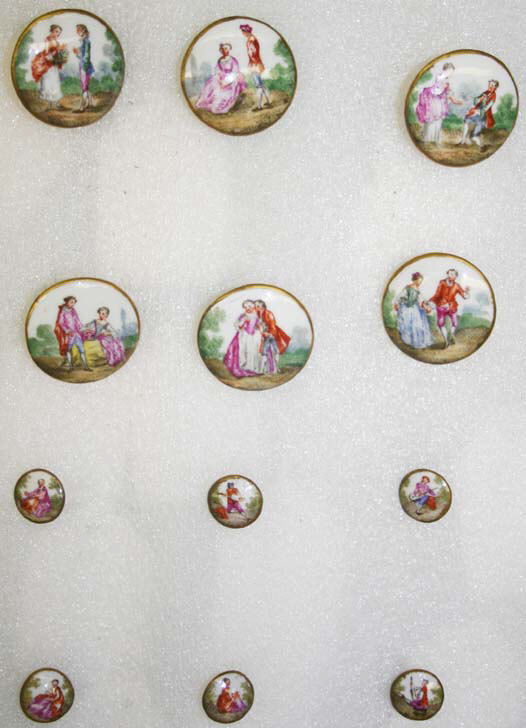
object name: button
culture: french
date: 1785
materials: porcelain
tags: musical instruments,men,women